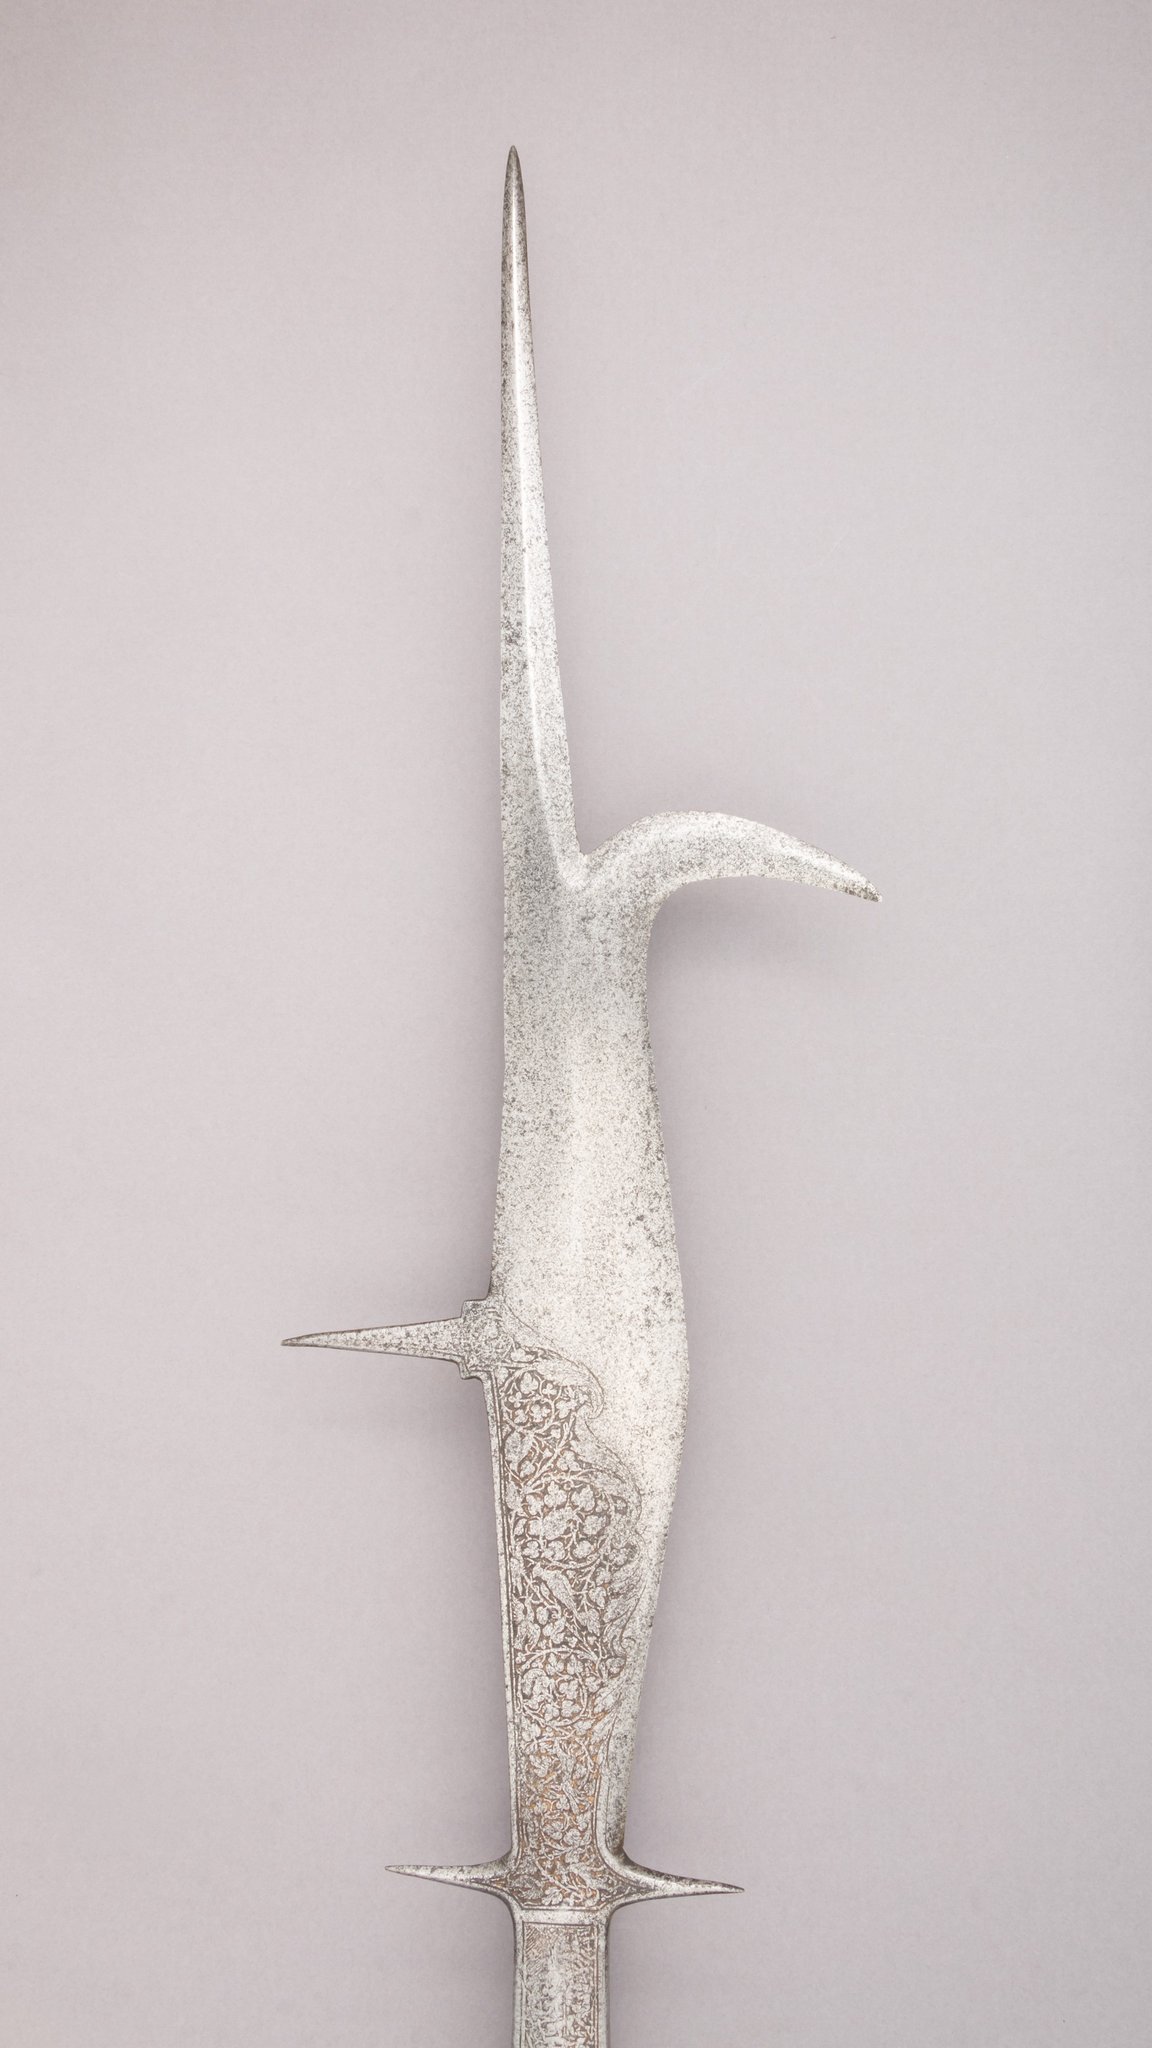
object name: guisarme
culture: italian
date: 1501-1600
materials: metal thread, steel, textile, wood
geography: italy